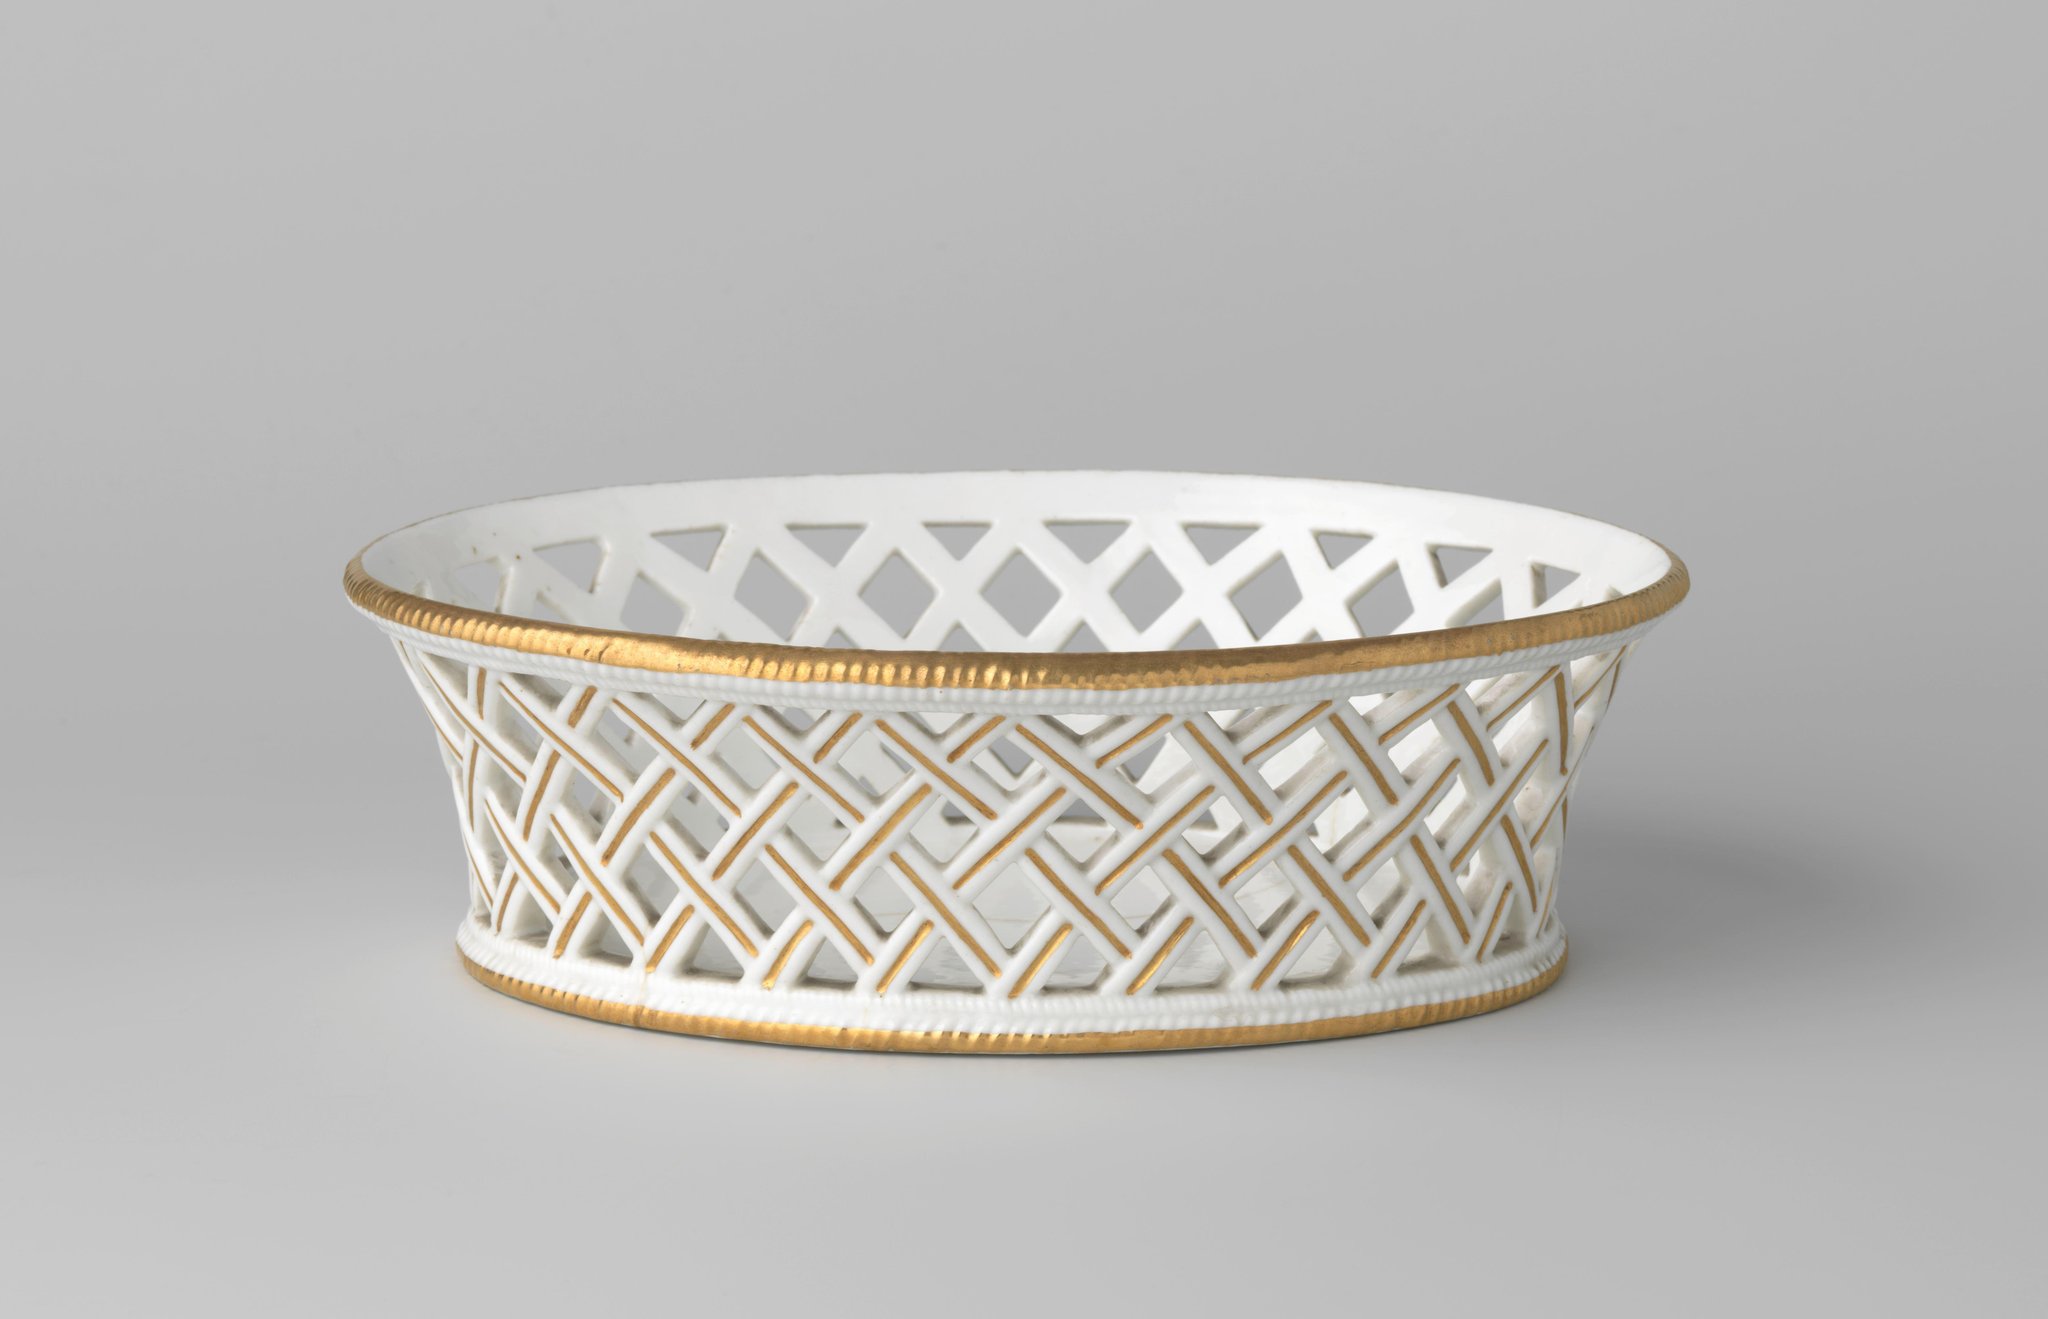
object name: basket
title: Basket with pierced sides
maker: Anonymous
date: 1790-1800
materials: glaze, gold, paint, porcelain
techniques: firing, forming, gilding, turning, vitrification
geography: paris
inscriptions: mark: ‘EB’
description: Mand, ovaal, van porselein, behorend bij servies, versierd in goud met een bloem- en bladkrans en met het alliantiewapen van Hendrik Peter Godfried Quack en Isabella Gertraud von Carnap. Merk: ingegrifte letters FC en in onderglazuur blauw de letters EB. Opmerking: barsten in bodem en wand.